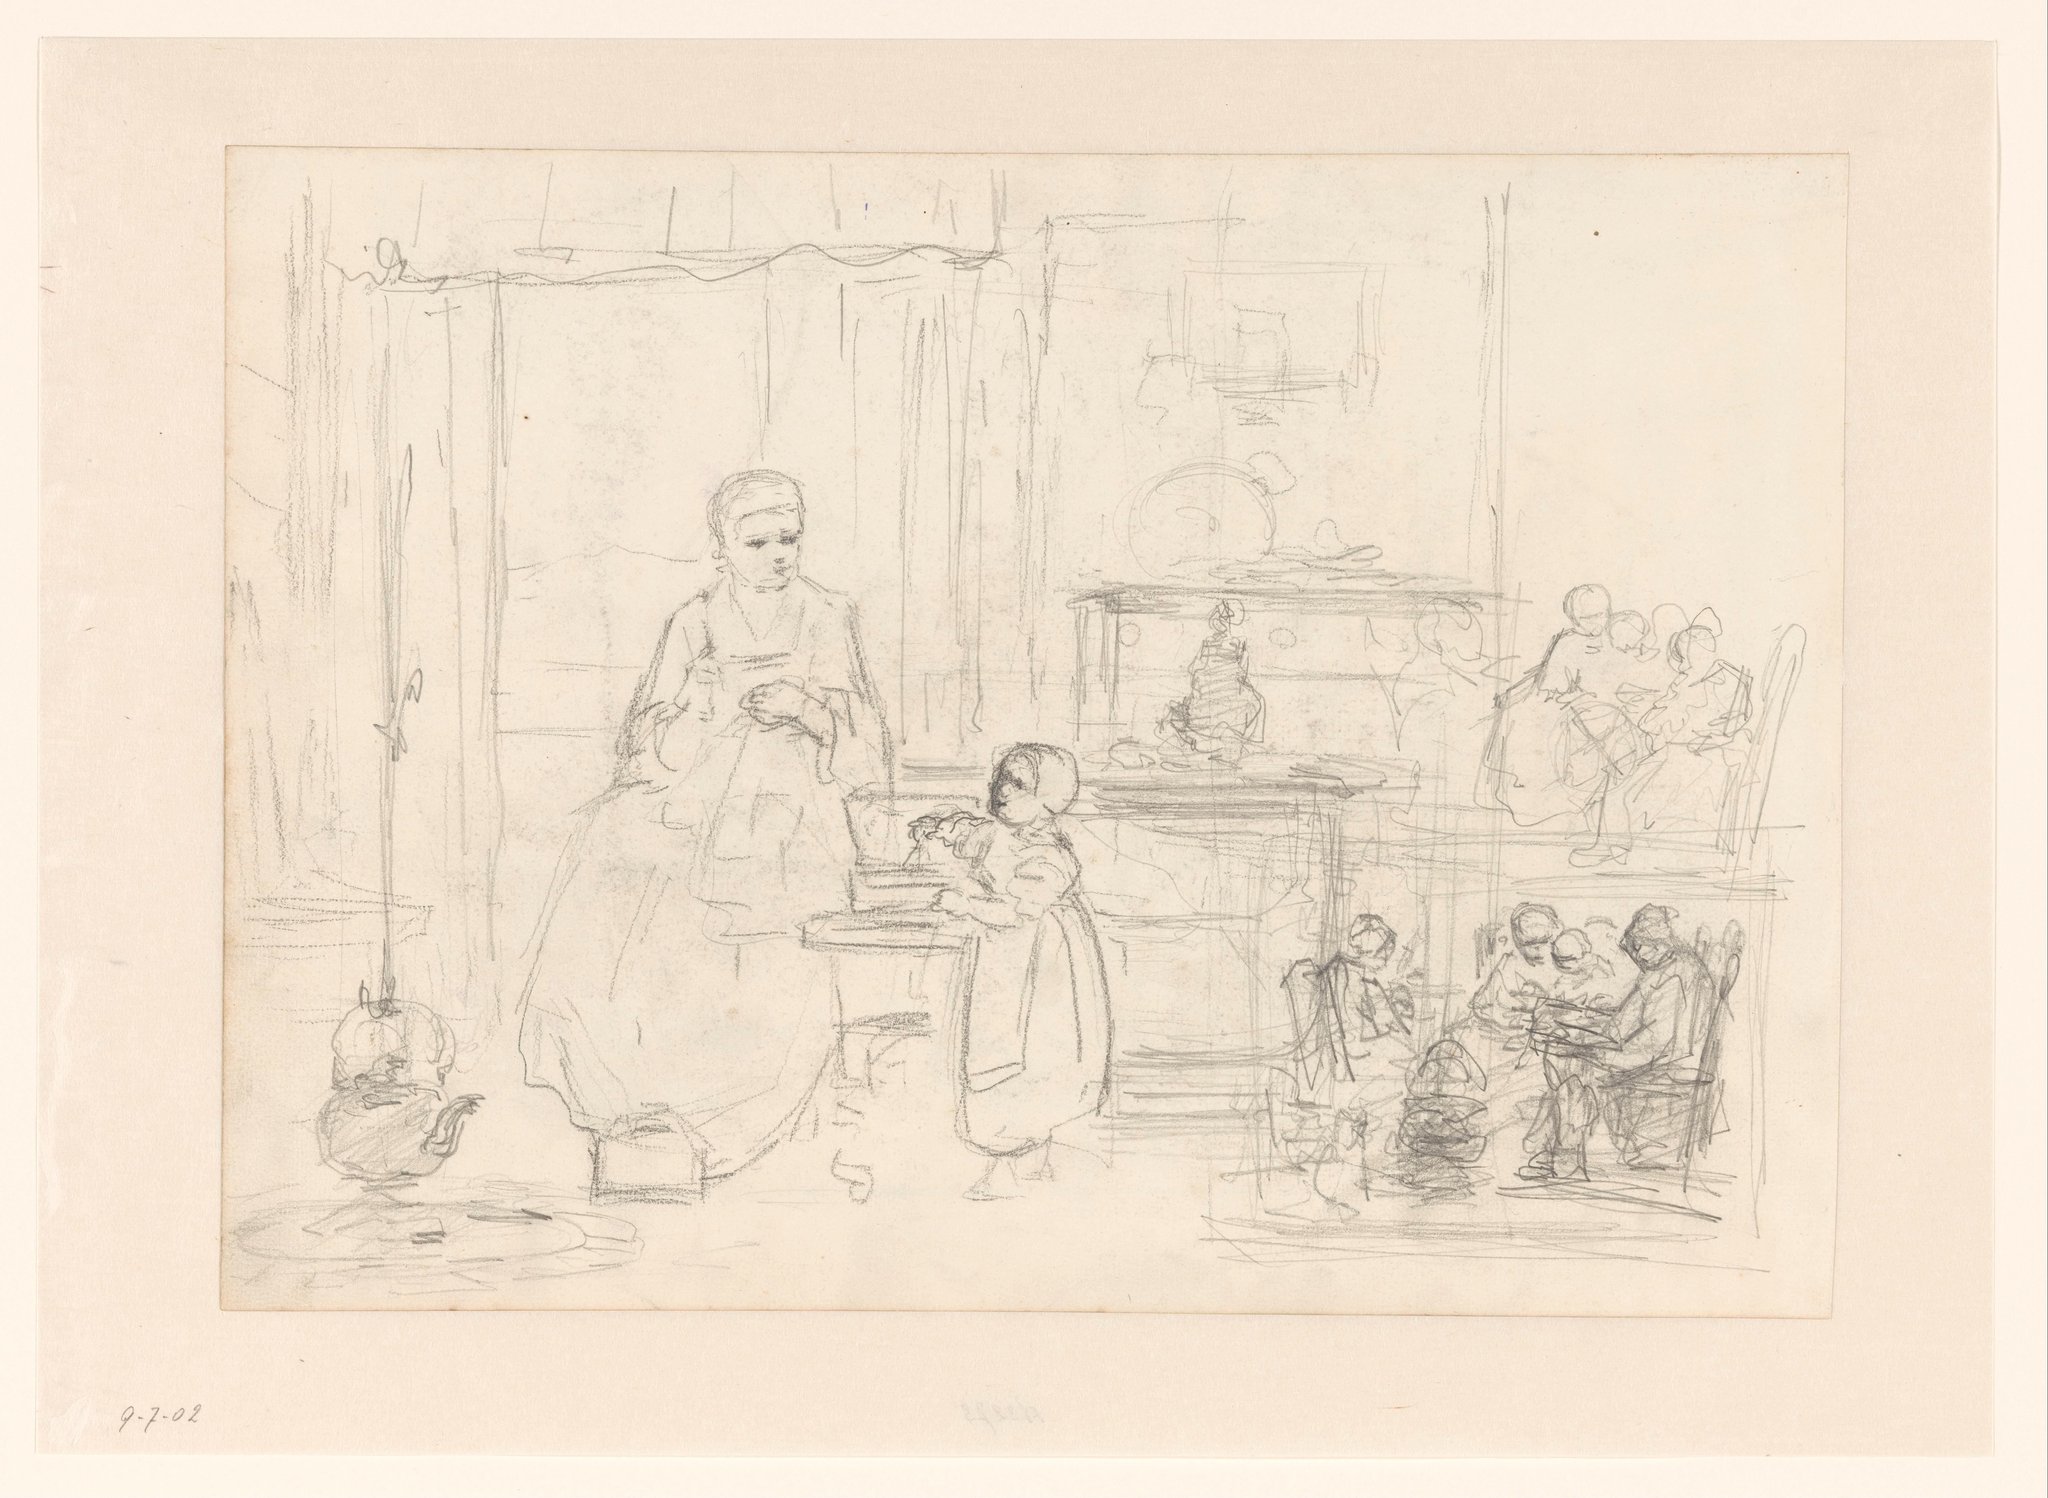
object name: drawing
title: Schetsen van groepjes mensen in interieur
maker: hendrik valkenburg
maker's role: draughtsman, painter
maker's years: 1826-1896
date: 1836-1896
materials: paper, pencil